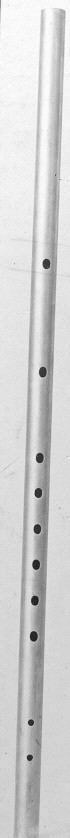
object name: transverse flute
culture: bornean or chinese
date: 1867-1900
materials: brass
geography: borneo